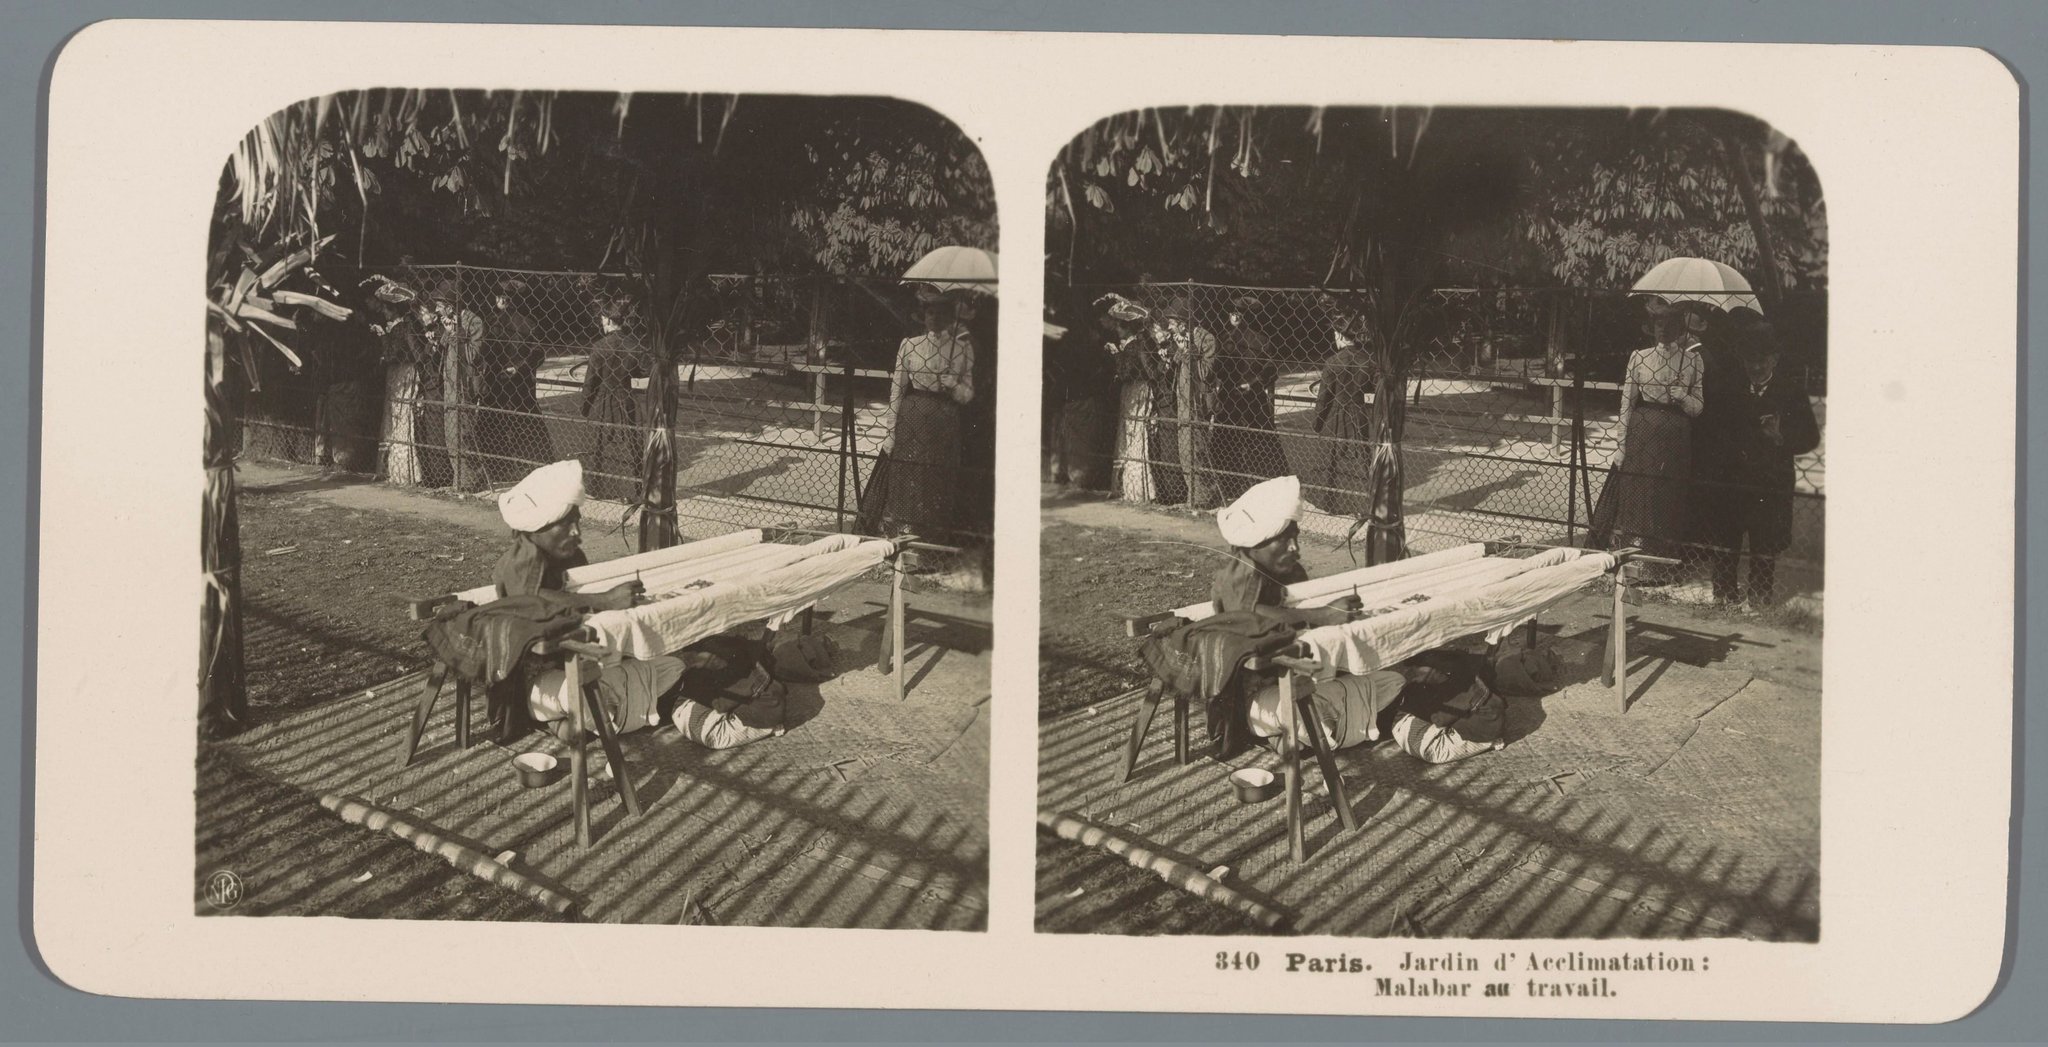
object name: stereograph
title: Paris. Jardin d'acclimatation: malabar au travail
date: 1900-1910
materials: cardboard, photographic support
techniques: gelatin silver print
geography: jardin d'acclimatation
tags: working class, labourers, botanic garden, 'hortus botanicus', greenhouse, orangery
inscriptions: number: ‘340’, inscription: ‘NPG’